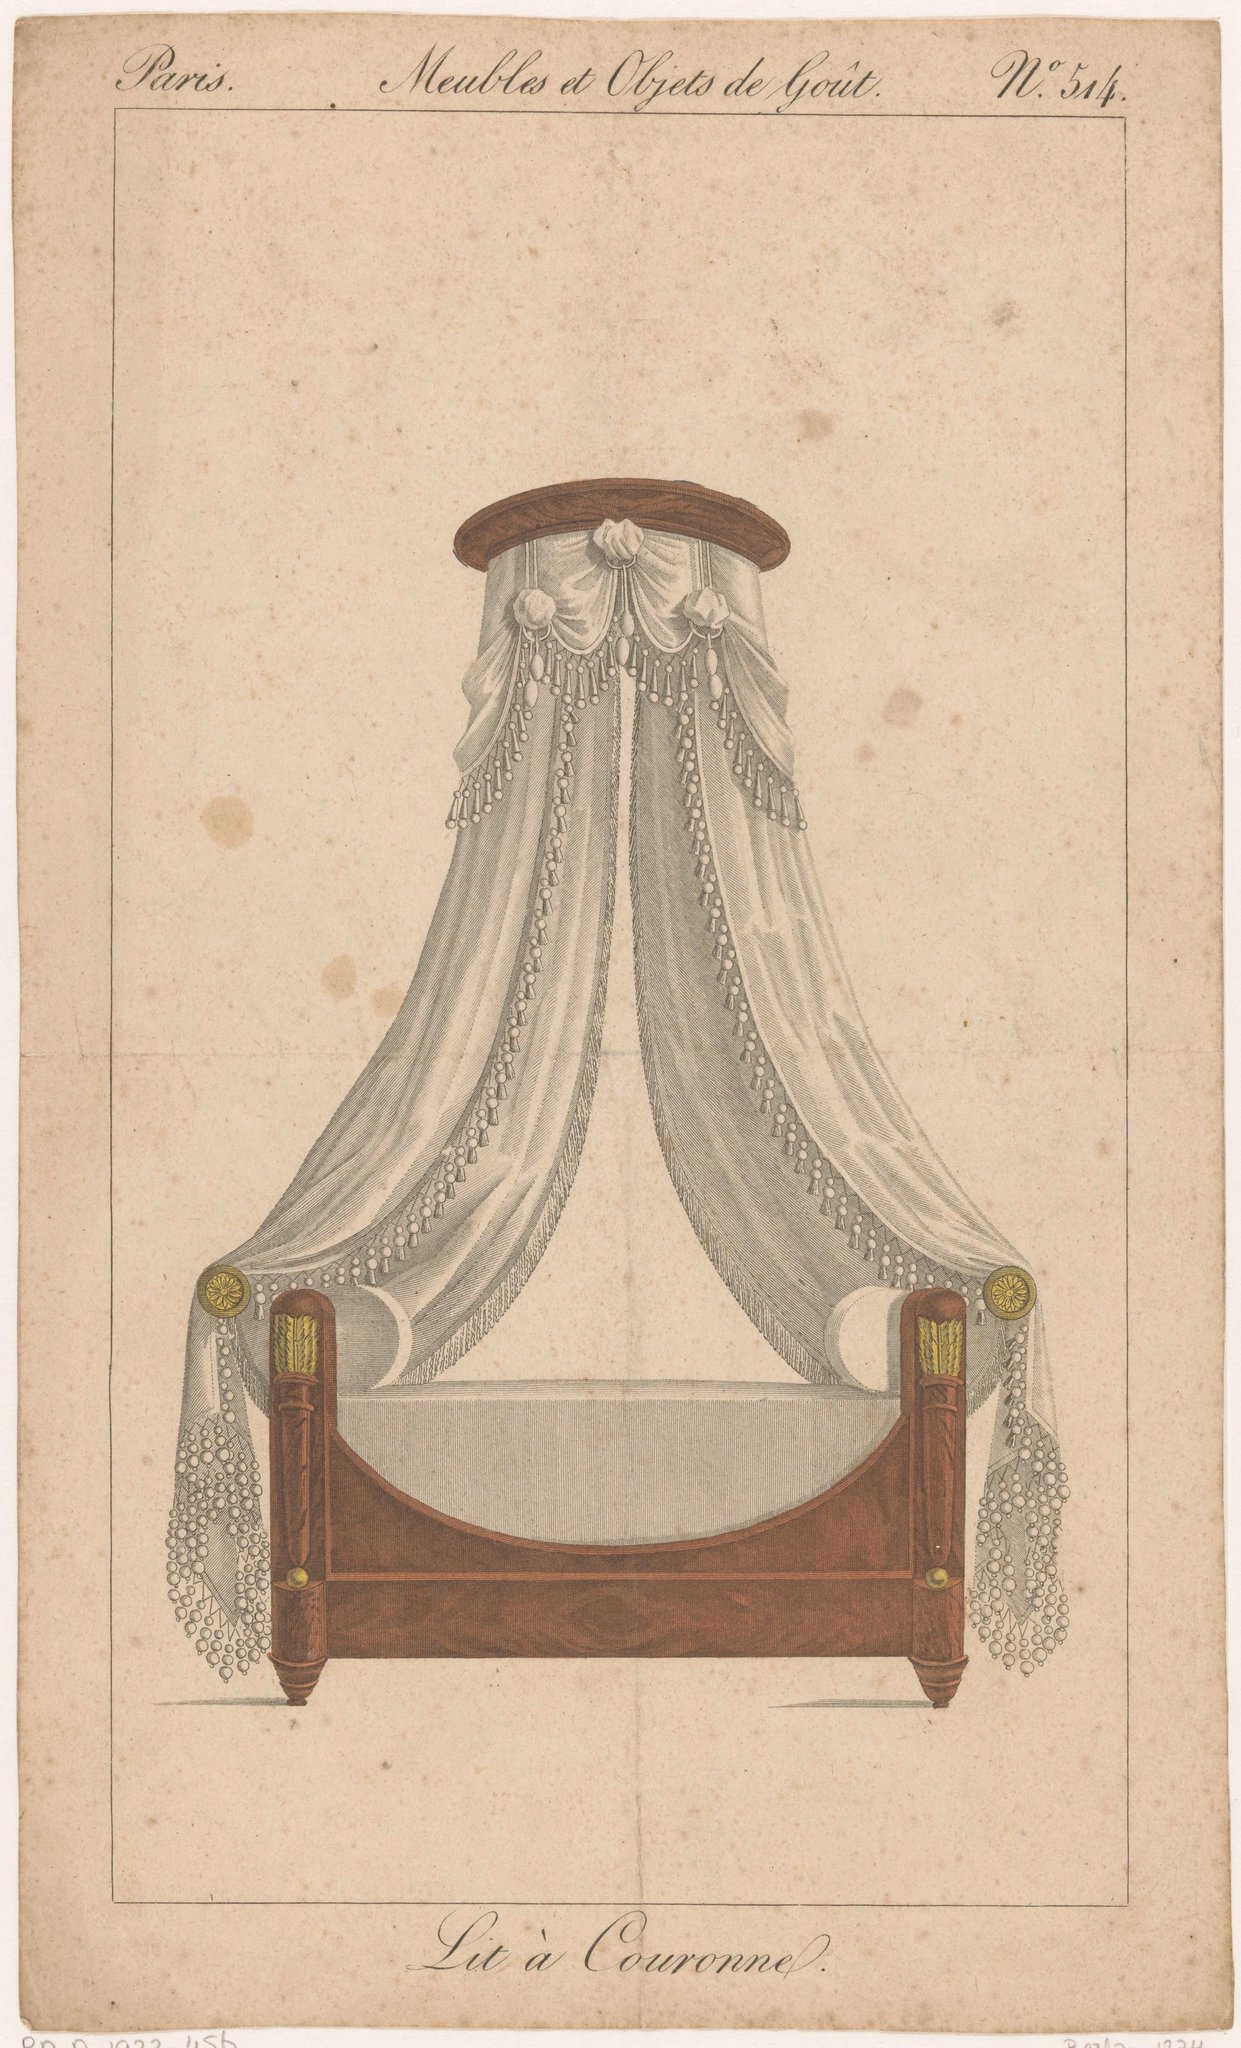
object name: print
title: Hemelbed met pijlenkokers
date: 1801-1831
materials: paper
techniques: engraving, hand coloring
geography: paris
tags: bed with tester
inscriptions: collector's mark: Lugt 2233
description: Een ontwerp voor een hemelbed gedecoreerd met pijlenkokers. Prentnummer 514.